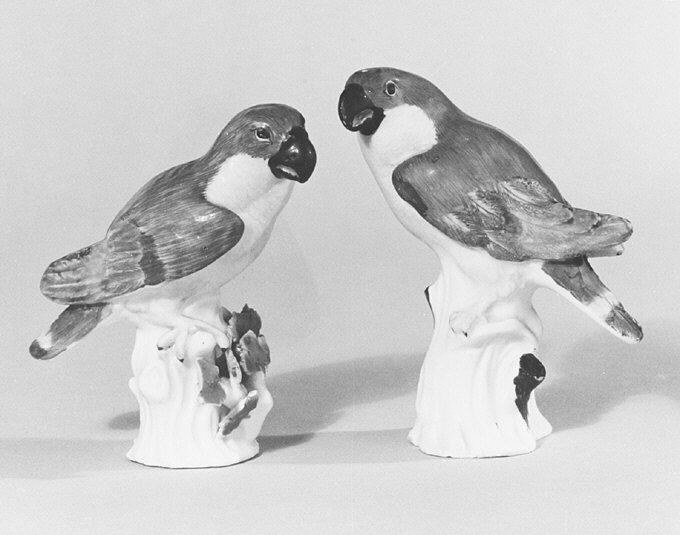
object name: figure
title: Parrot (one of a pair)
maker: meissen manufactory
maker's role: manufactory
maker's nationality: german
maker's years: 1710-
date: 1741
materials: hard paste porcelain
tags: parrots